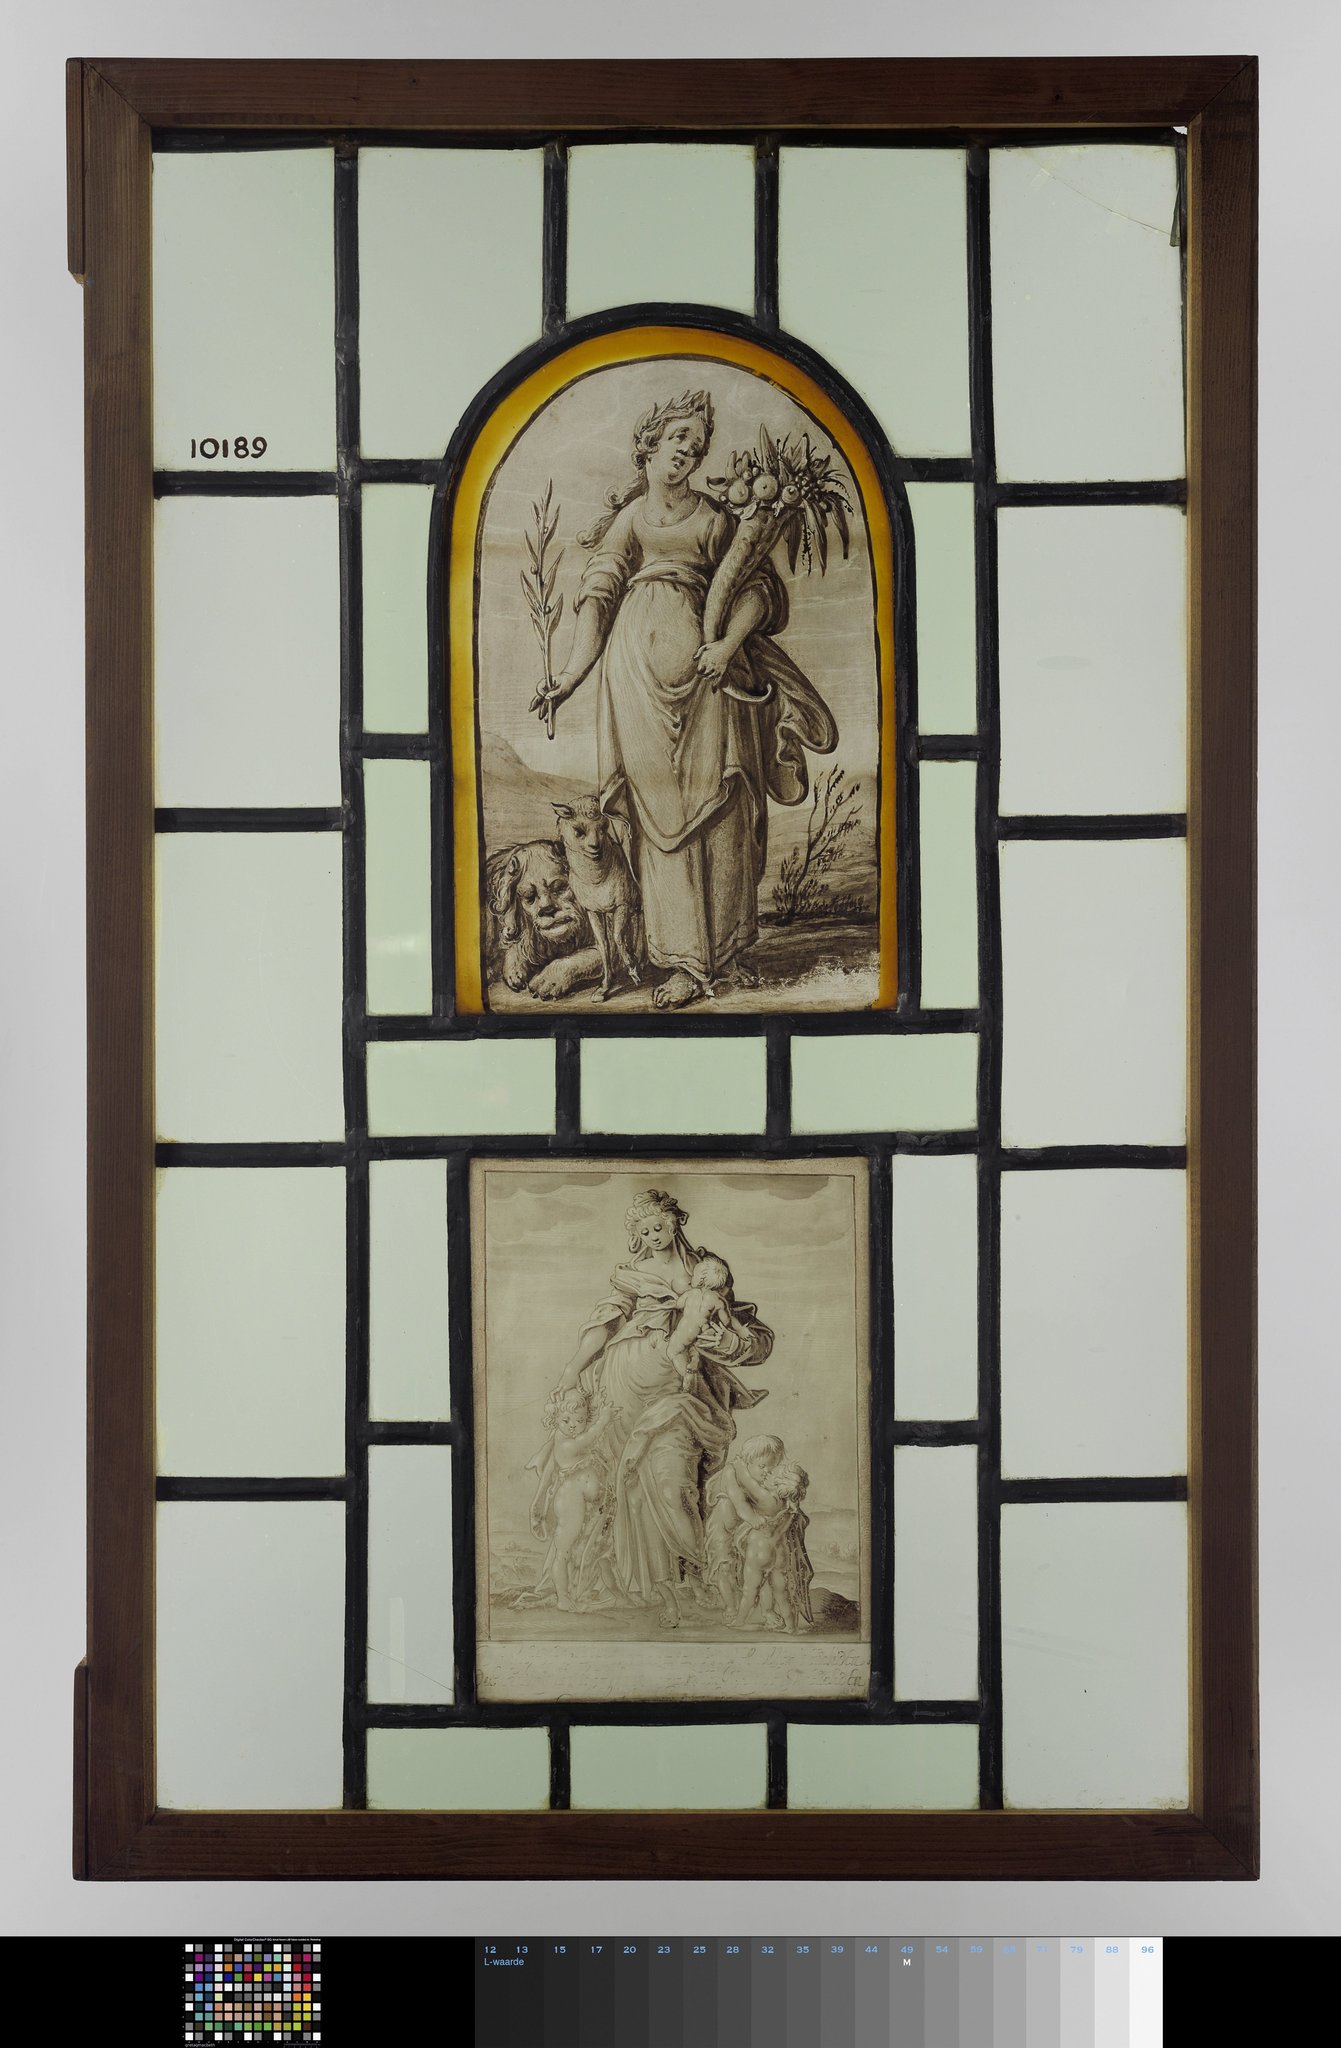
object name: light window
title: Ruit met personificatie van de Vrede en de Liefde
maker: Anonymous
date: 1700-1800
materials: glass, lead, pigment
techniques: leading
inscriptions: inscription: ‘De liefde ist fondament beginsel aller deuchden, Die hier geen liefden heeft ist hierna geen vreuchden.’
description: Paneel met personificatie van de Vrede (de bovenste ruit) en de Liefde (de onderste ruit). De Vrede heeft aan haar voeten een leeuw en een schaap. De Liefde toont een staande vrouw met vier kinderen, waarvan een op haar arm.